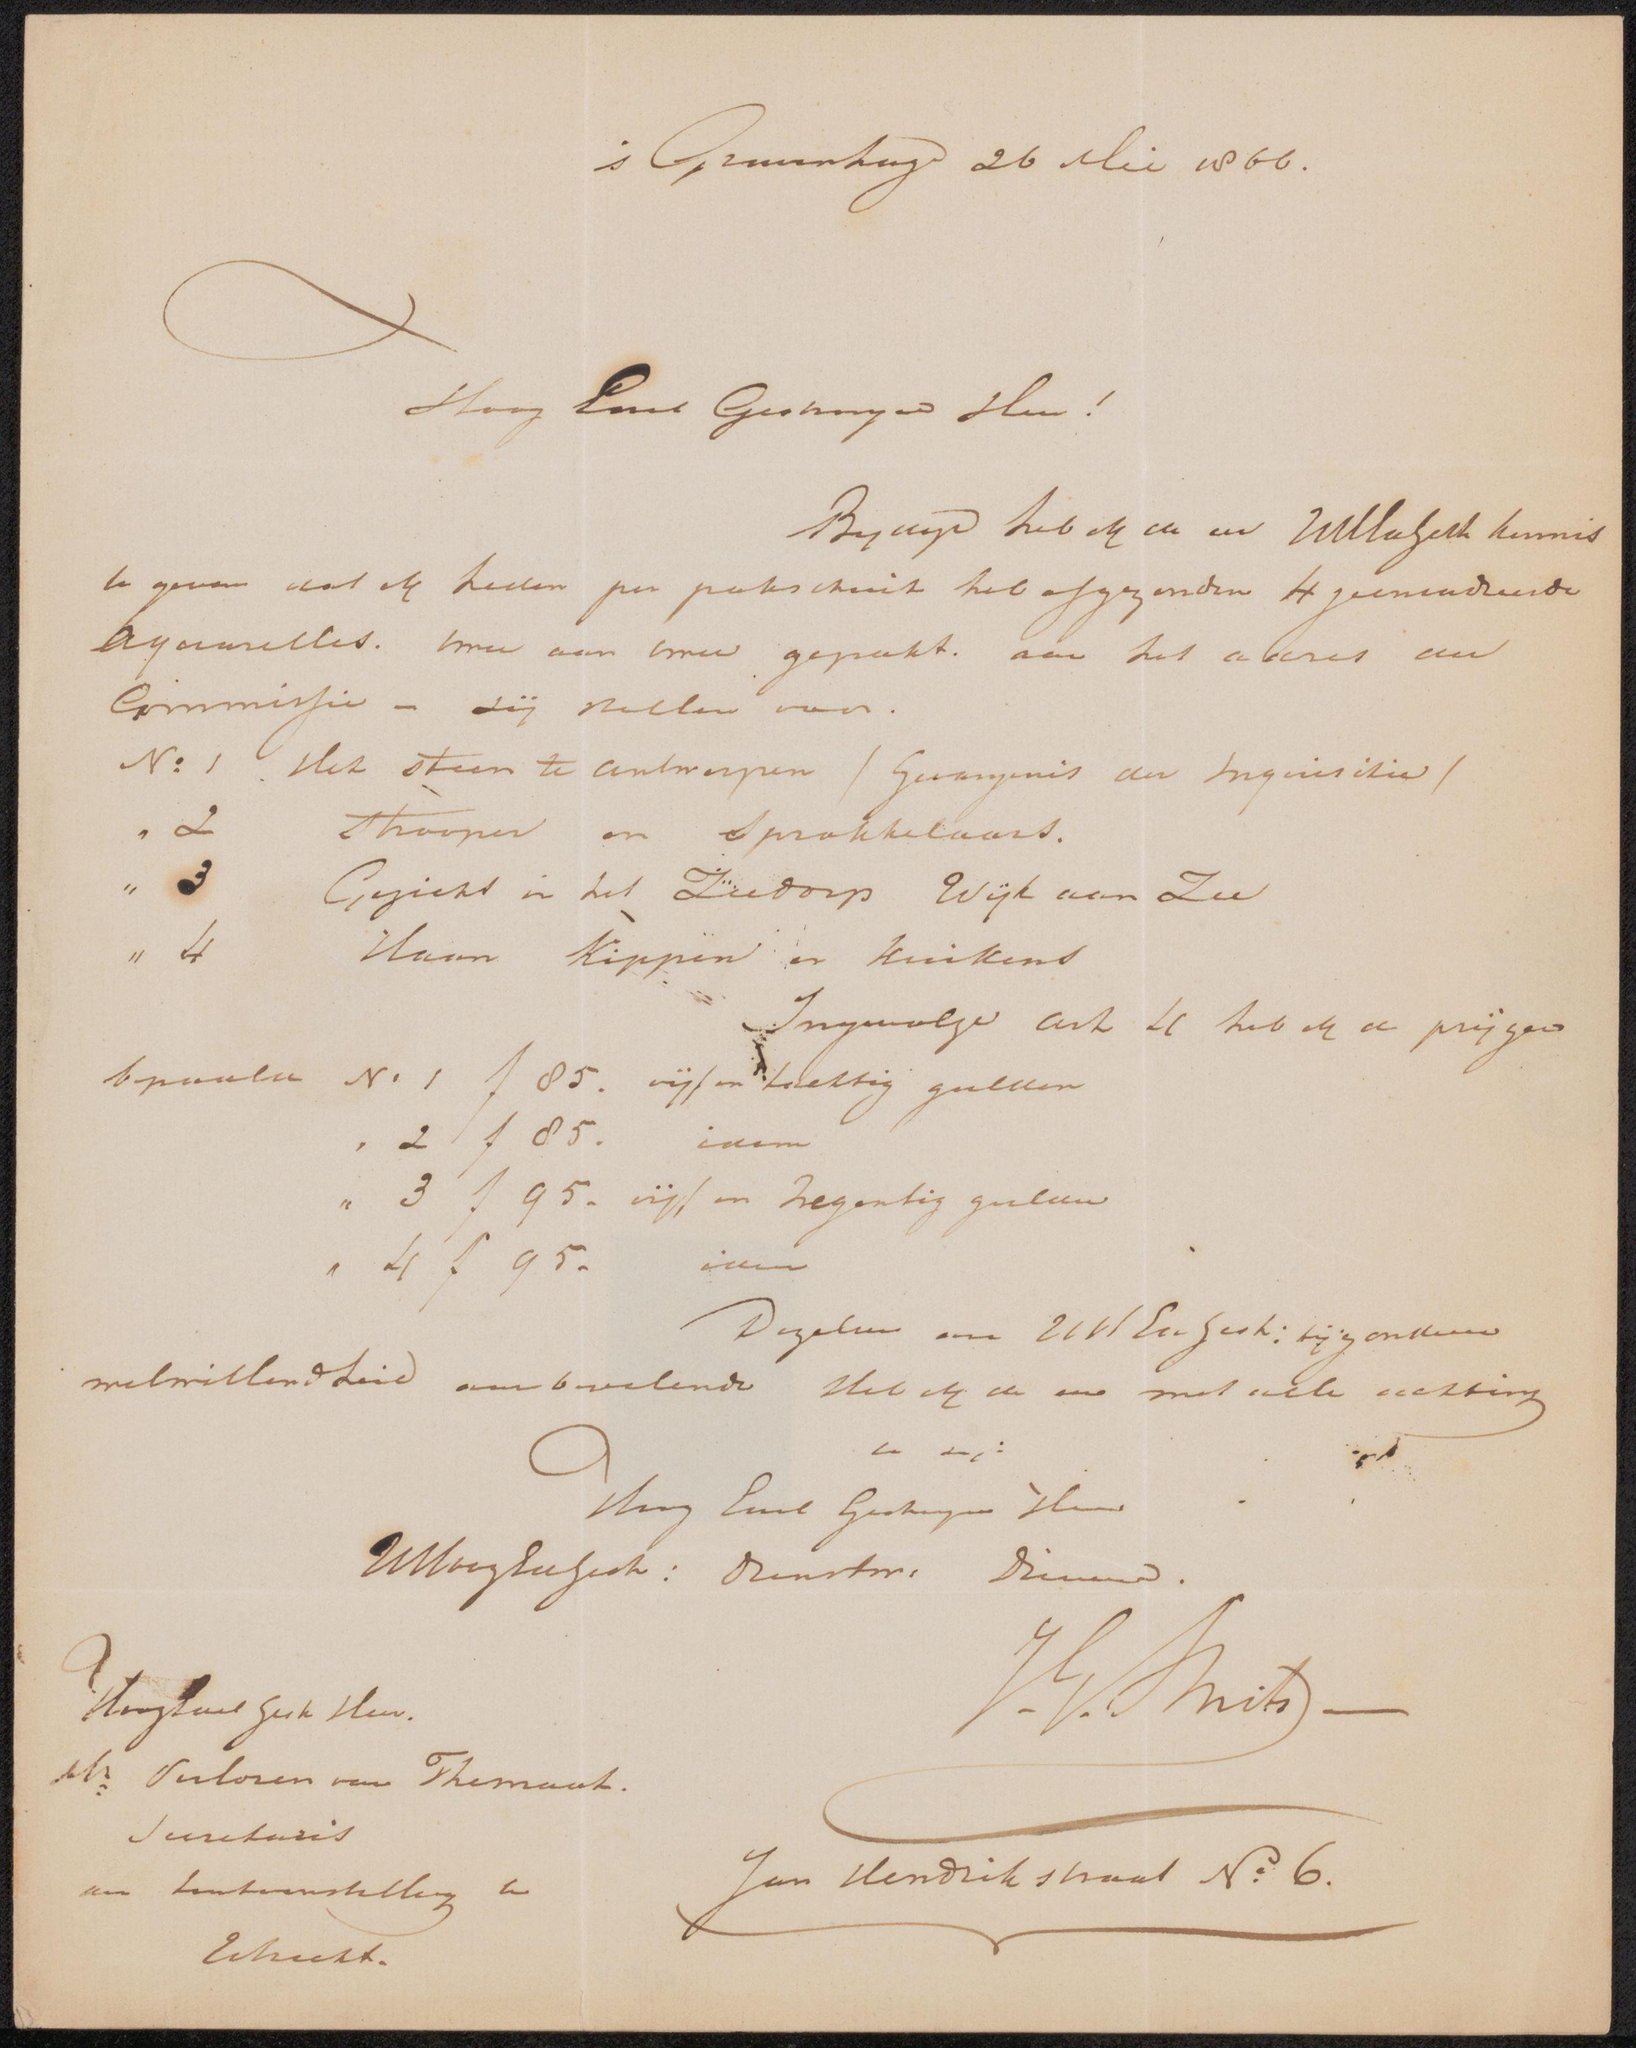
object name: letter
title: Brief aan Pieter Verloren van Themaat, secretaris van de Commissie van de Tentoonstelling van Levende Meesters in Utrecht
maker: jan gerard smits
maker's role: draughtsman, print maker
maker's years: 1823-1910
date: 1866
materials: ink, paper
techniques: pen, writing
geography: the hague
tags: utrecht, pieter verloren van themaat, drawing, exhibition ~ art, money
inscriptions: seal, collector's mark: ‘RPK’